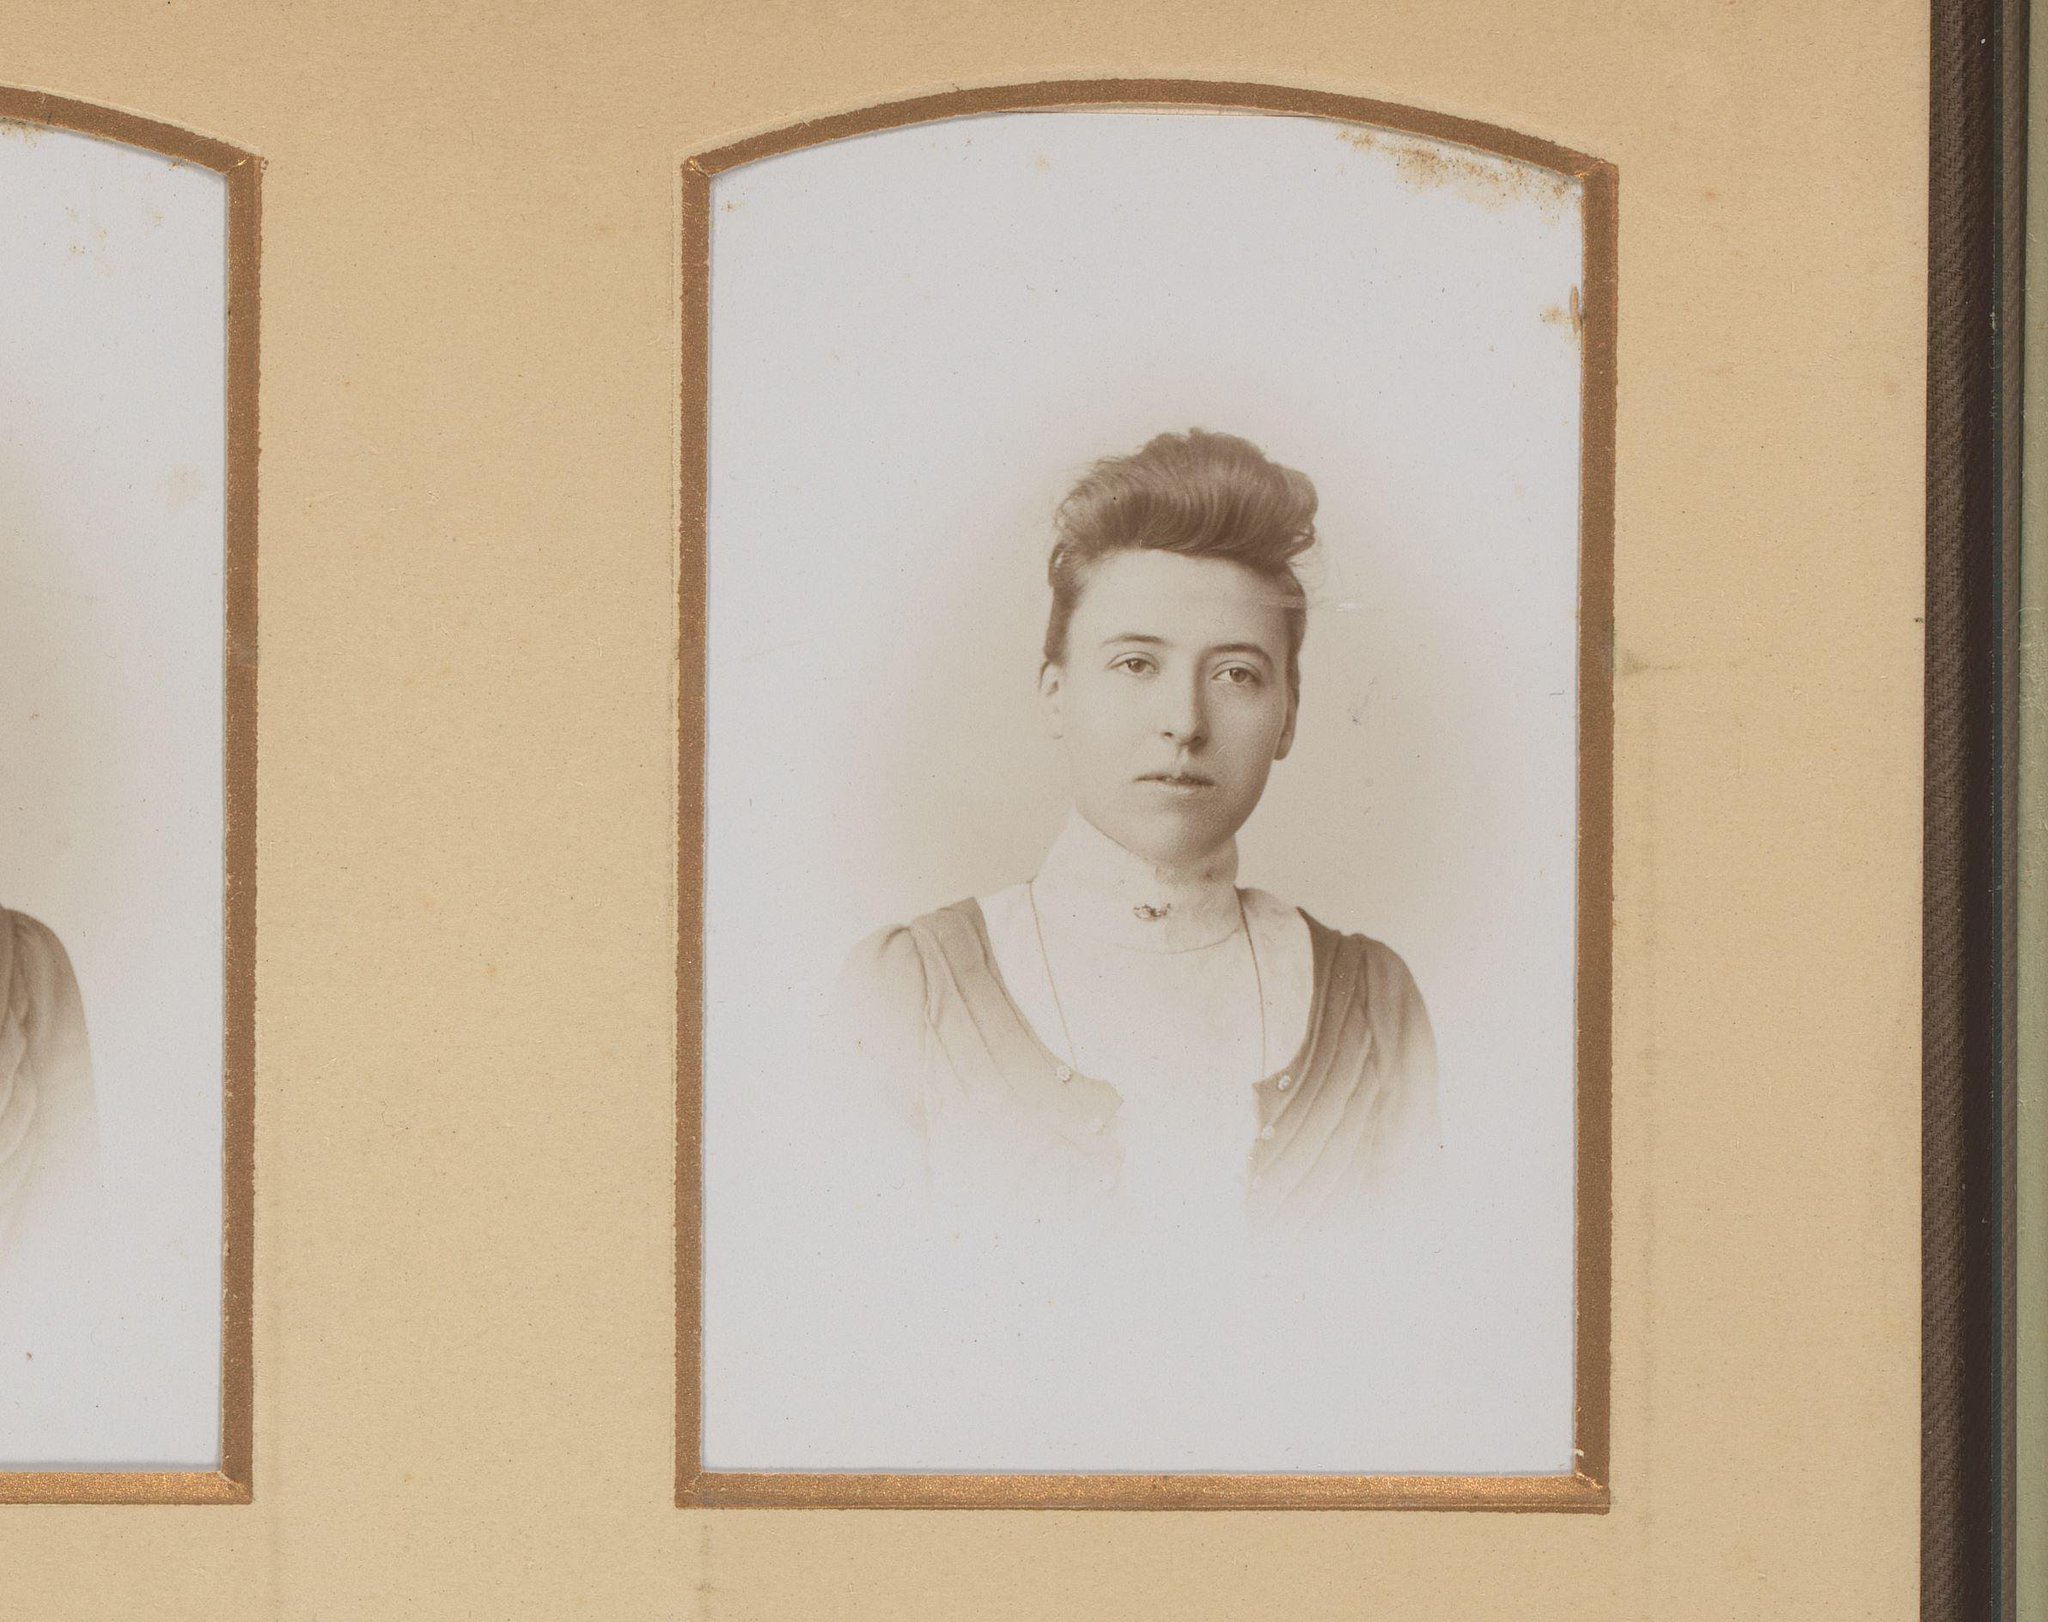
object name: photograph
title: Portret van een jonge vrouw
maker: e. v.d. kerkhoff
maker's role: fotograaf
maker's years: 1861-1943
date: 1895-1908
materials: cardboard, photographic support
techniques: collodion silver print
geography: amsterdam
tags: adolescent, young woman, maiden, historical persons - bb - woman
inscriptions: inscription: ‘Atelier/ E. v.d. Kerkhoff/ Amsterdam./ Keizersgracht, 455./ Hoek Leidschestraat./ Lift bij den Portier./ Vergrootingen naar dit en elk ander Portret/ worden prachtig uitgevoerd./ De Plaat blijft voor Nabestelling bewaard.’